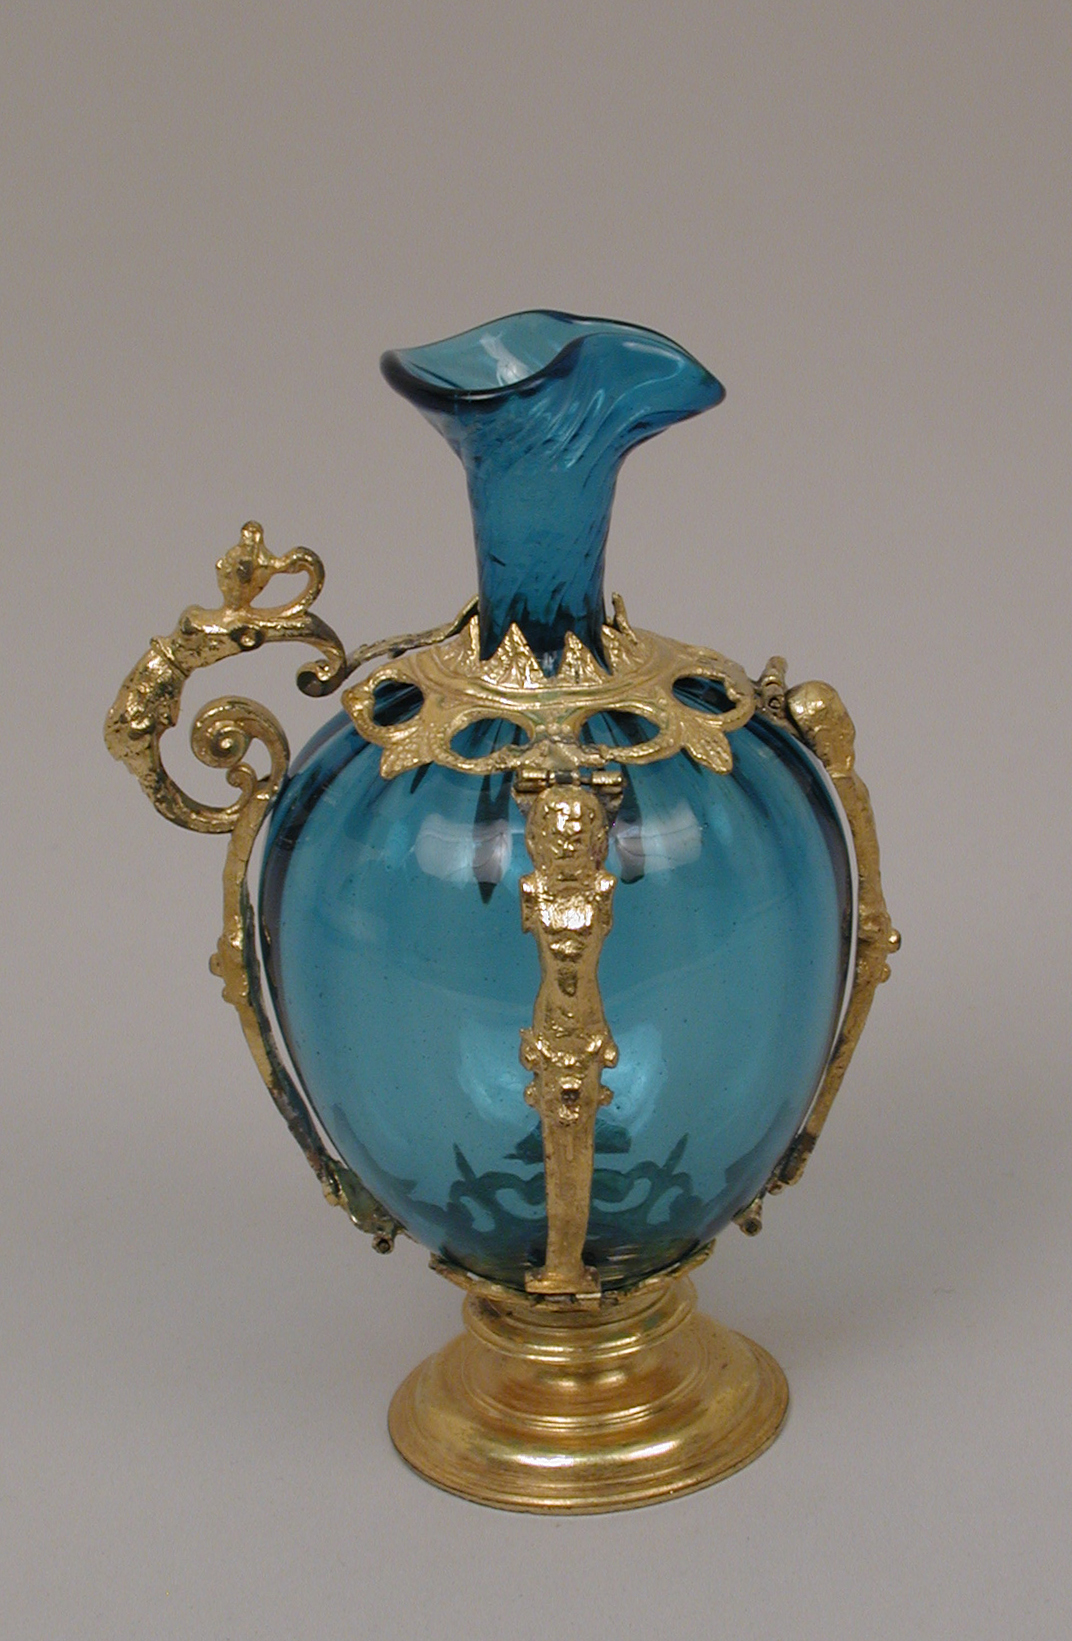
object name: ewer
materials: gilt bronze, glass